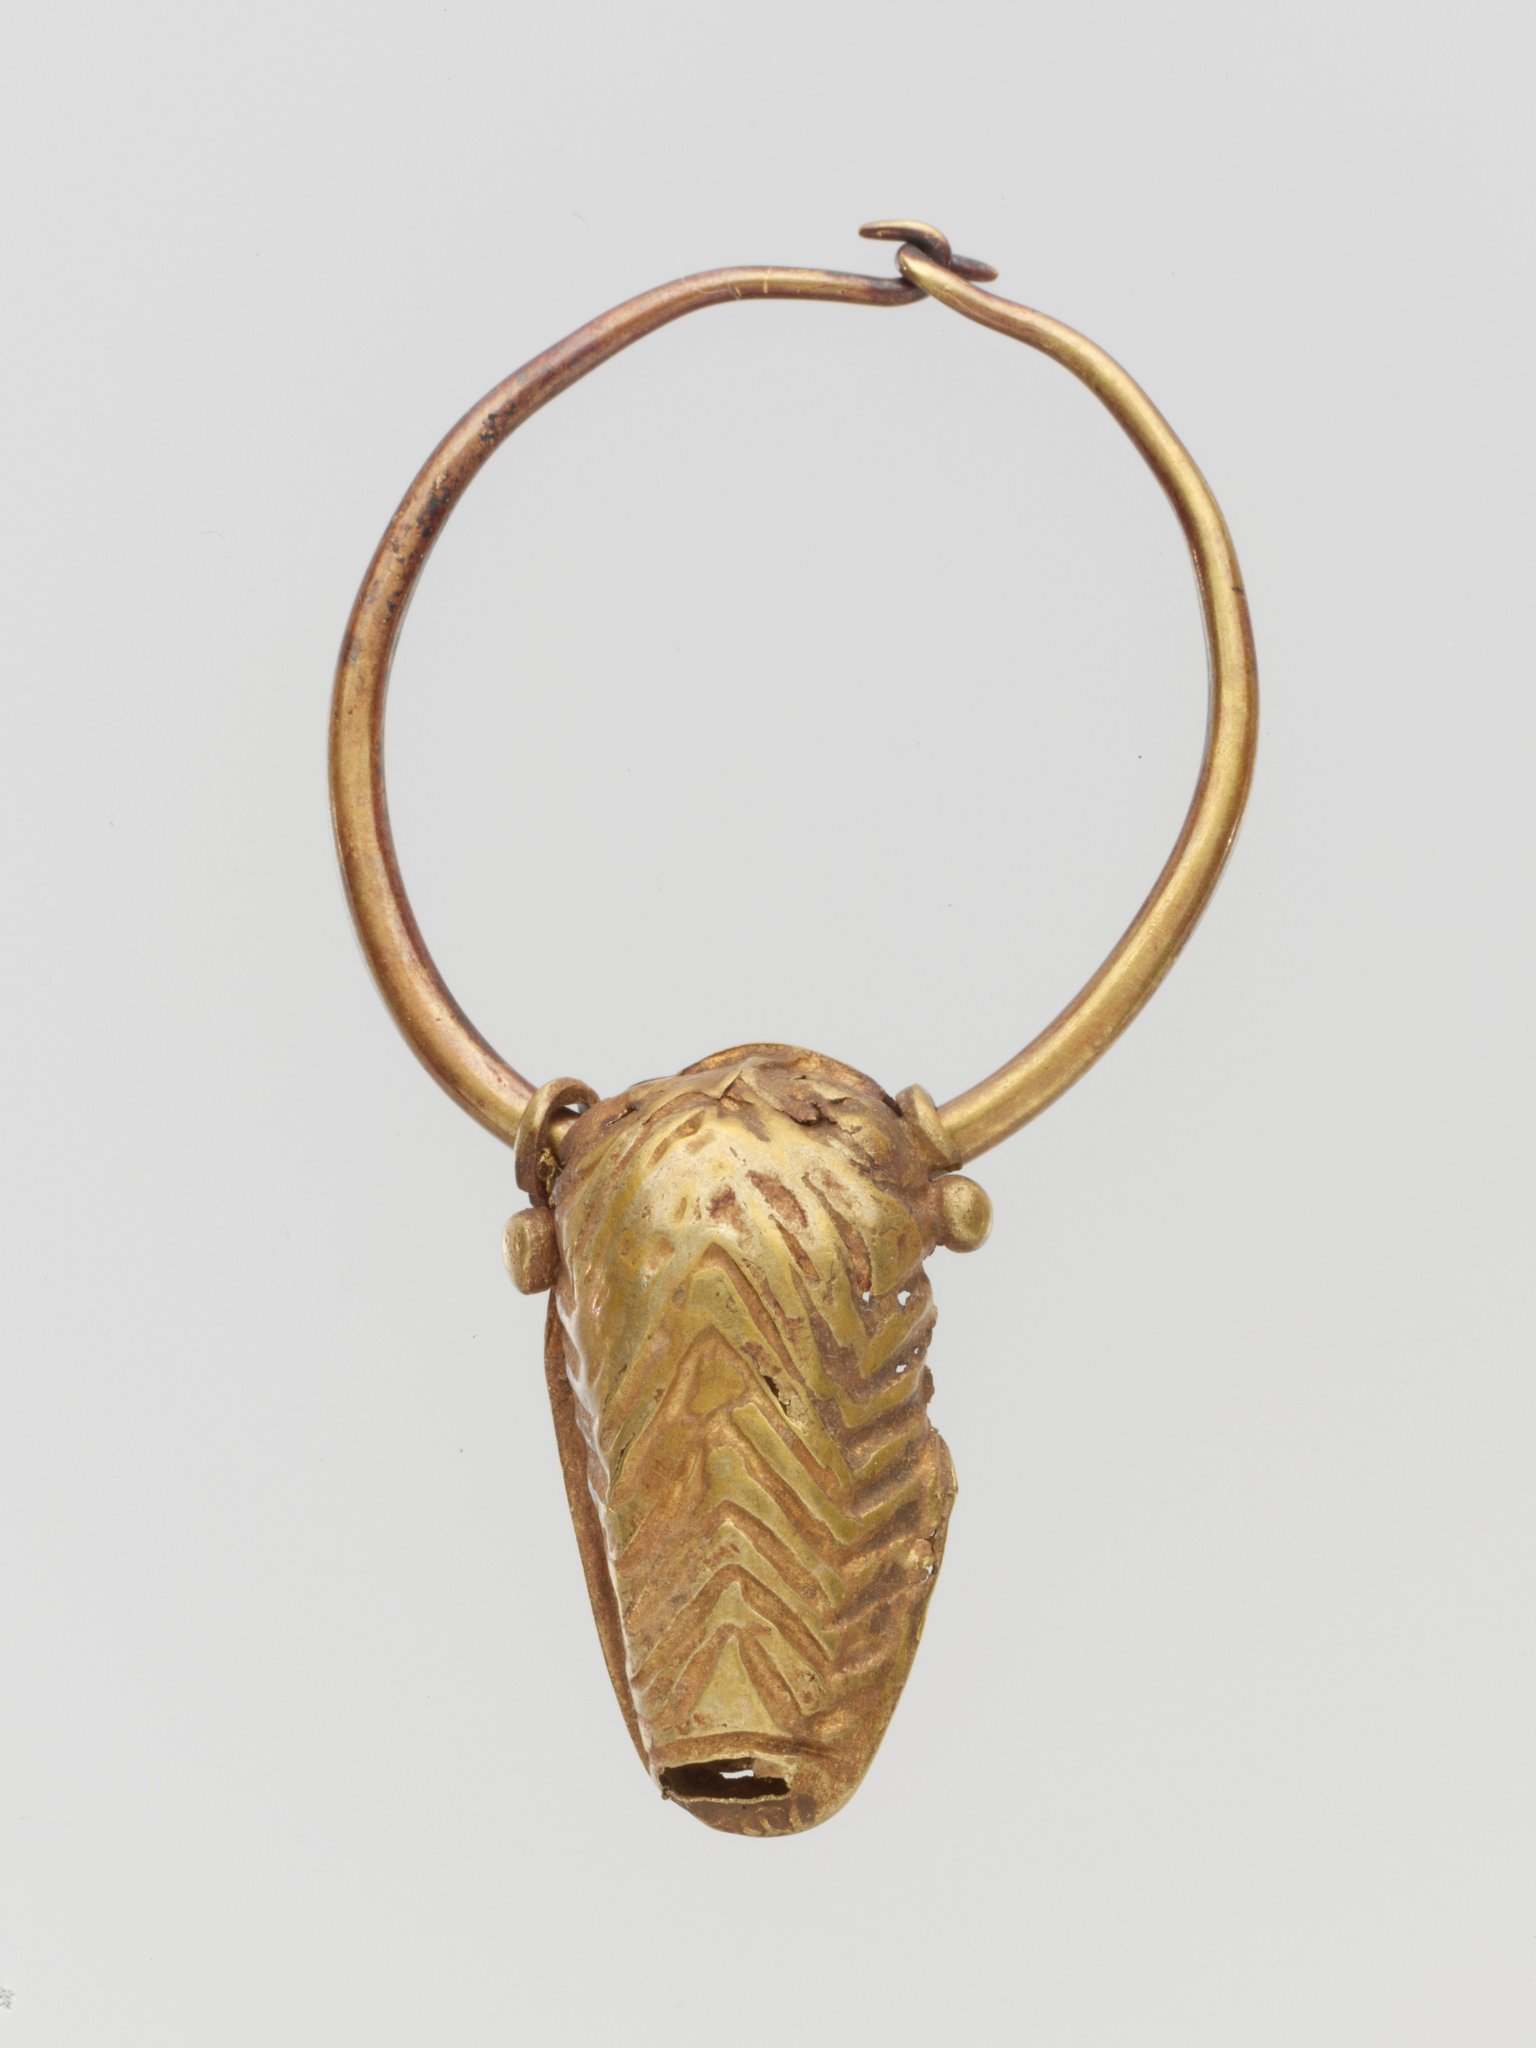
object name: earring with head of bull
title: Gold pendant in the form of a bull's head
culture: cypriot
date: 1400-1050 BCE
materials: gold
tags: bulls